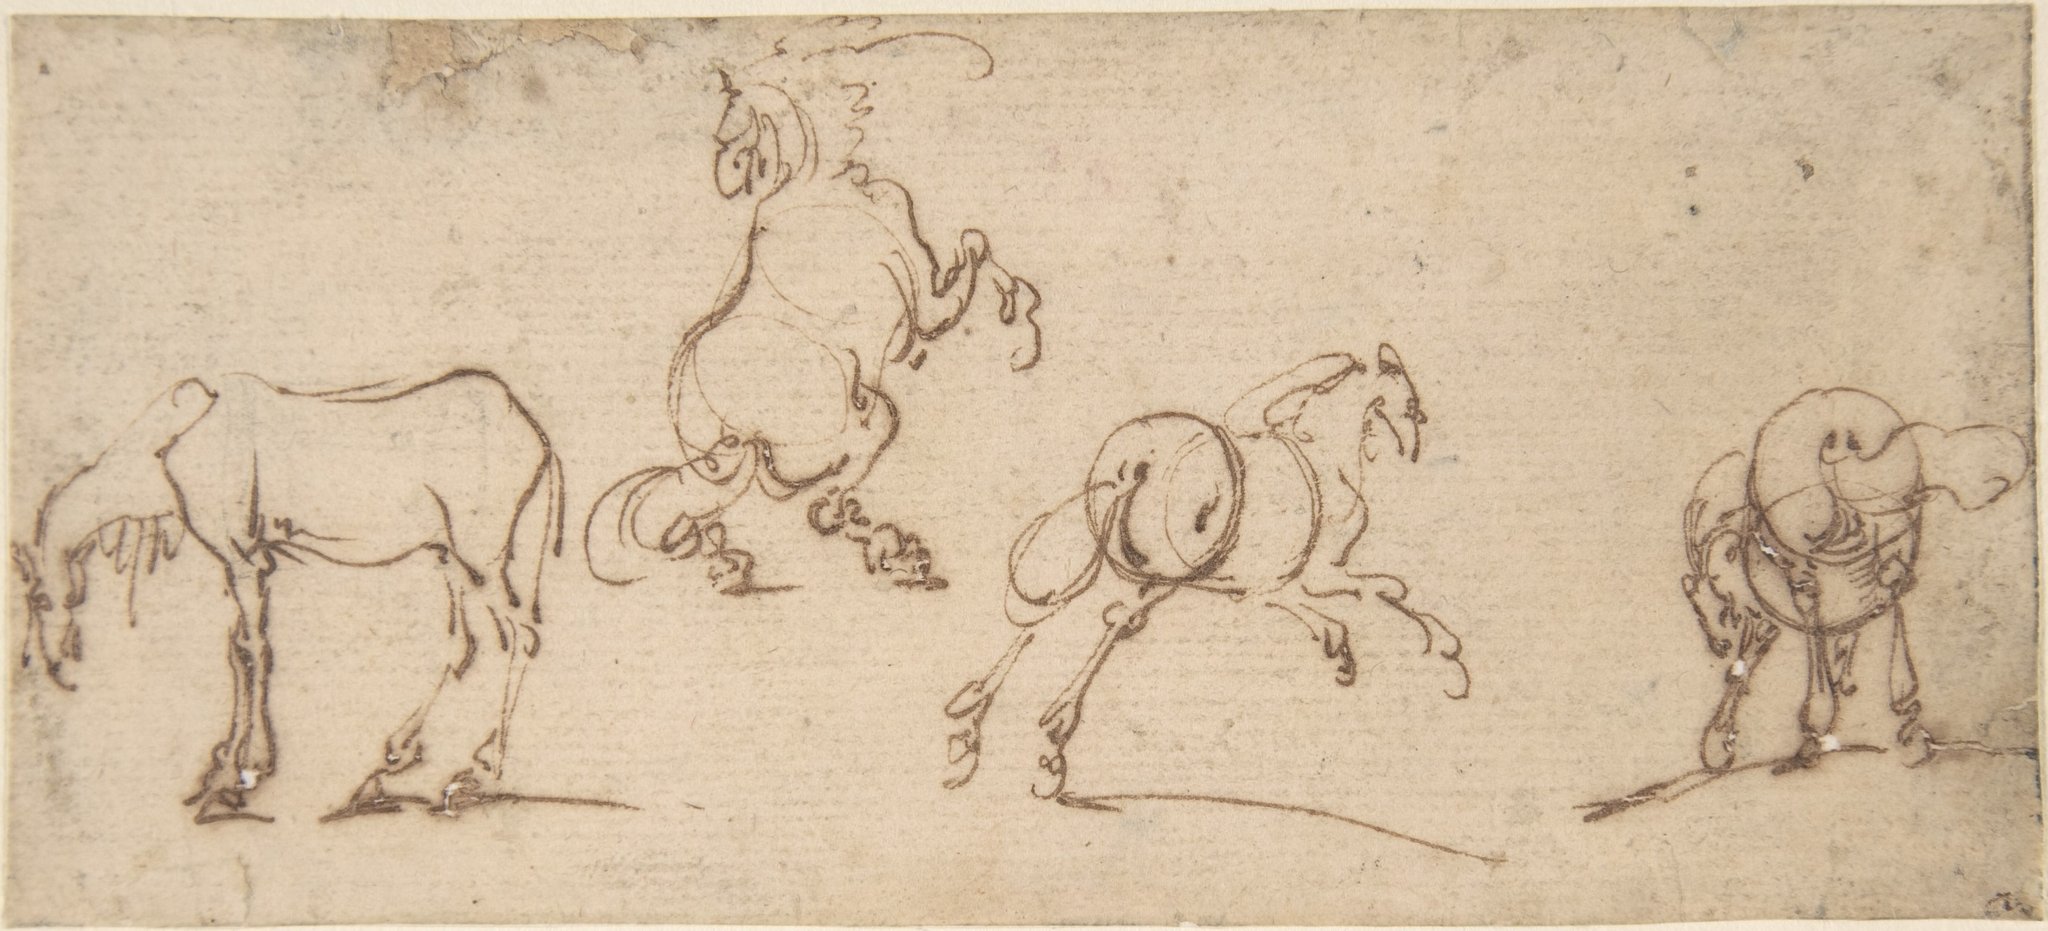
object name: drawing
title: Four Studies of Horses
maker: jacques callot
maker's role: artist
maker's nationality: french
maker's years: 1592-1635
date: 1501-1600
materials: ink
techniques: pen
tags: horses